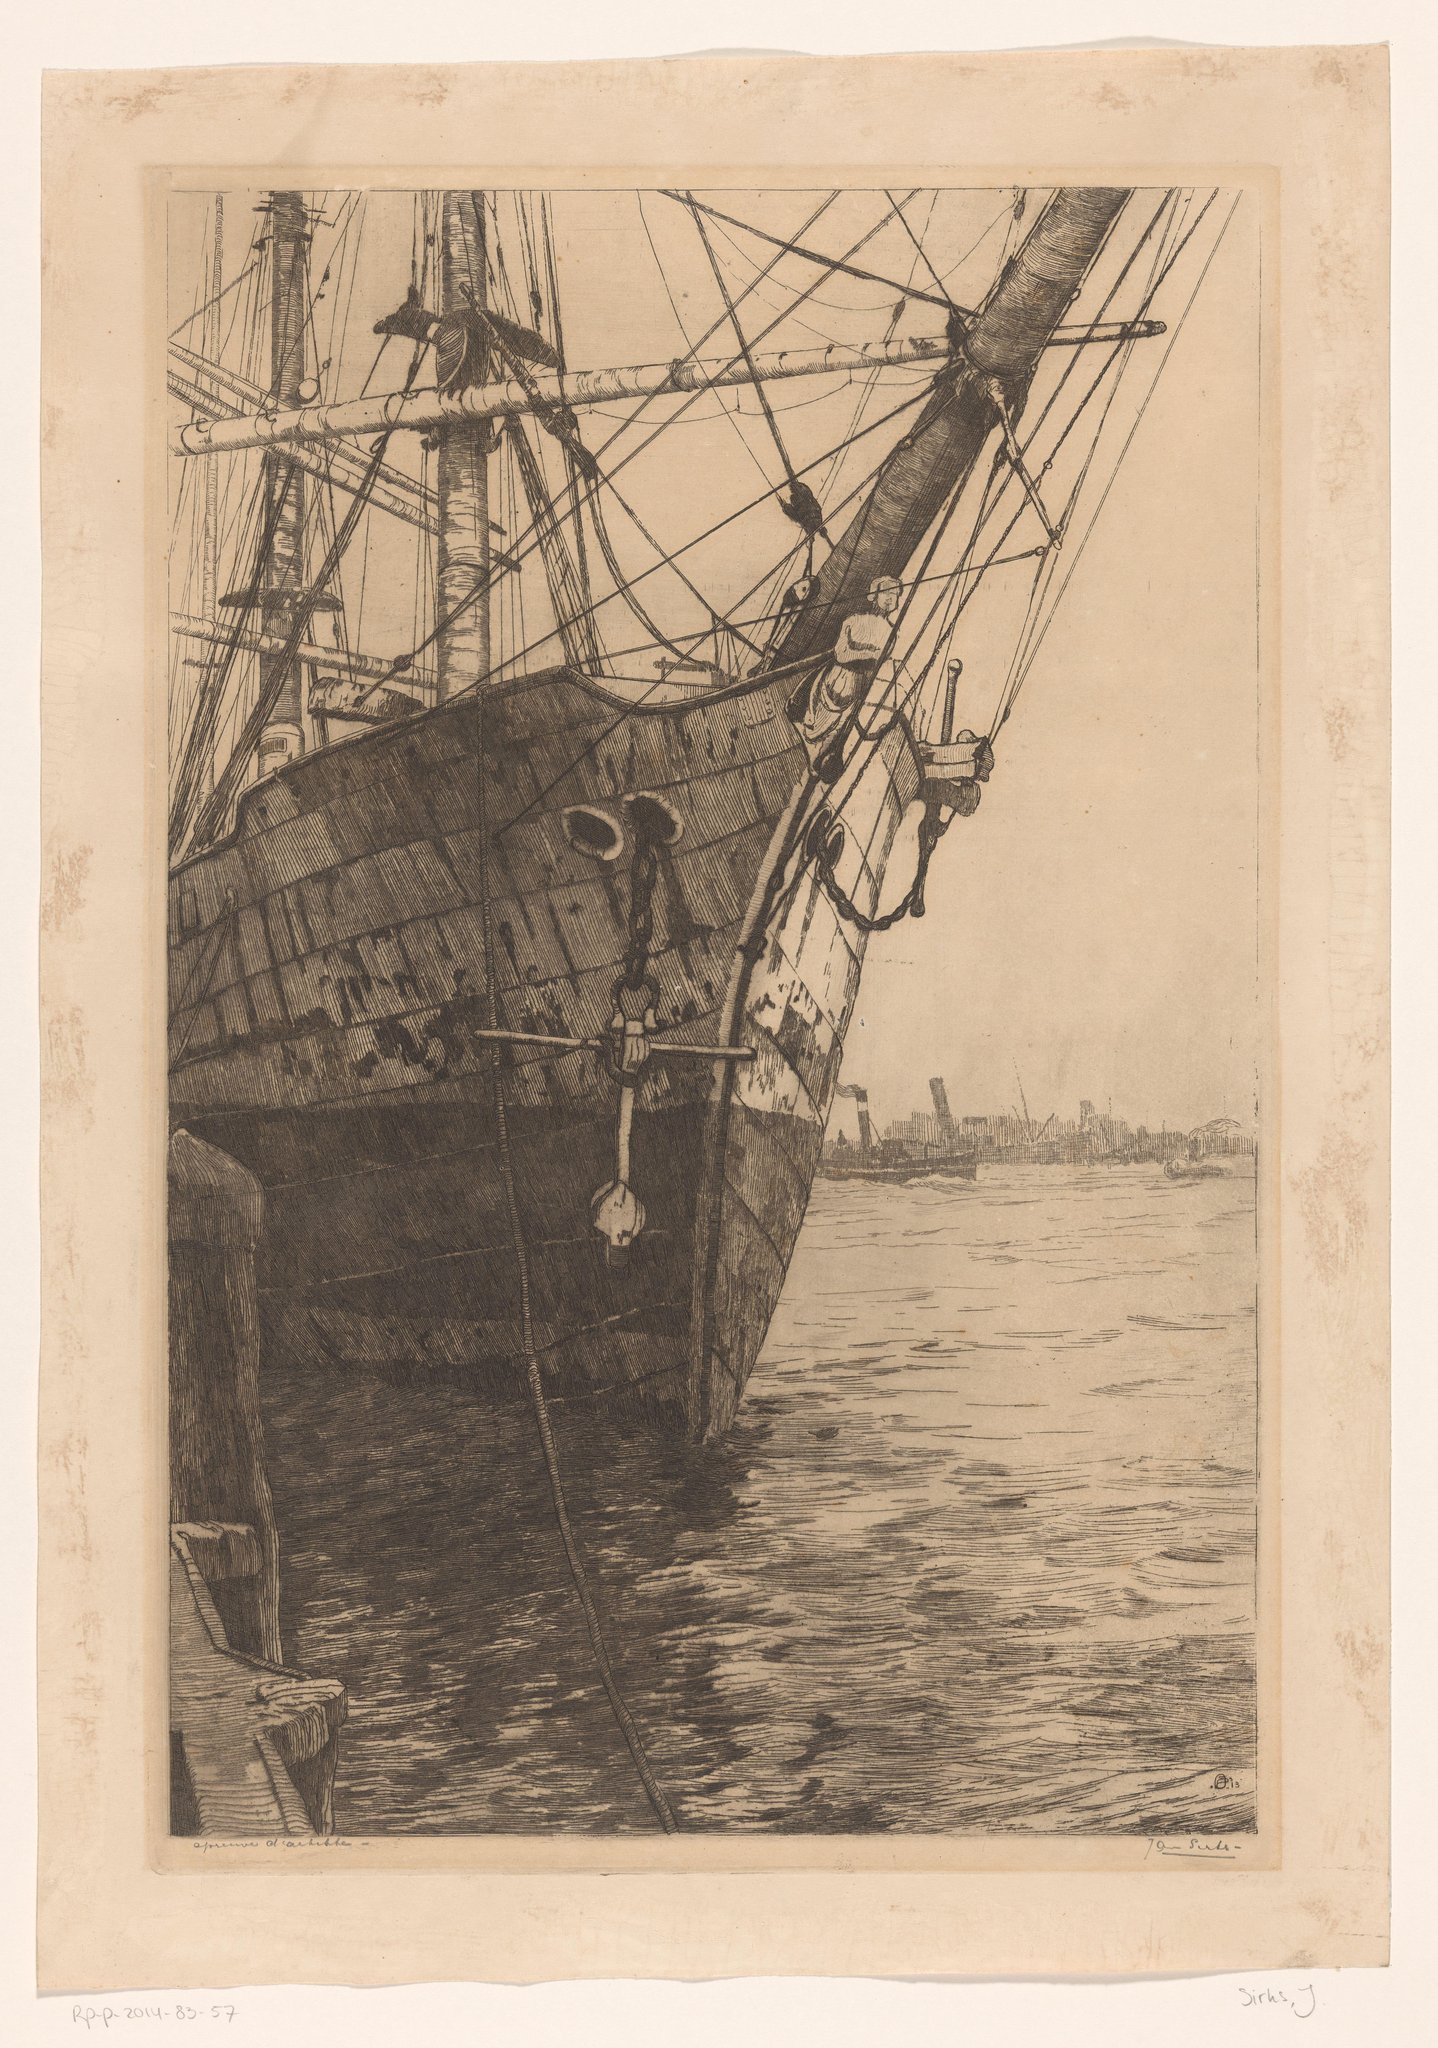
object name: print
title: Boeg van een schip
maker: jan sirks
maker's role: print maker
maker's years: 1885-1938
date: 1913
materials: paper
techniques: etching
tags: parts of ship's exterior: bow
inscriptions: date, collector's mark: Lugt 2228